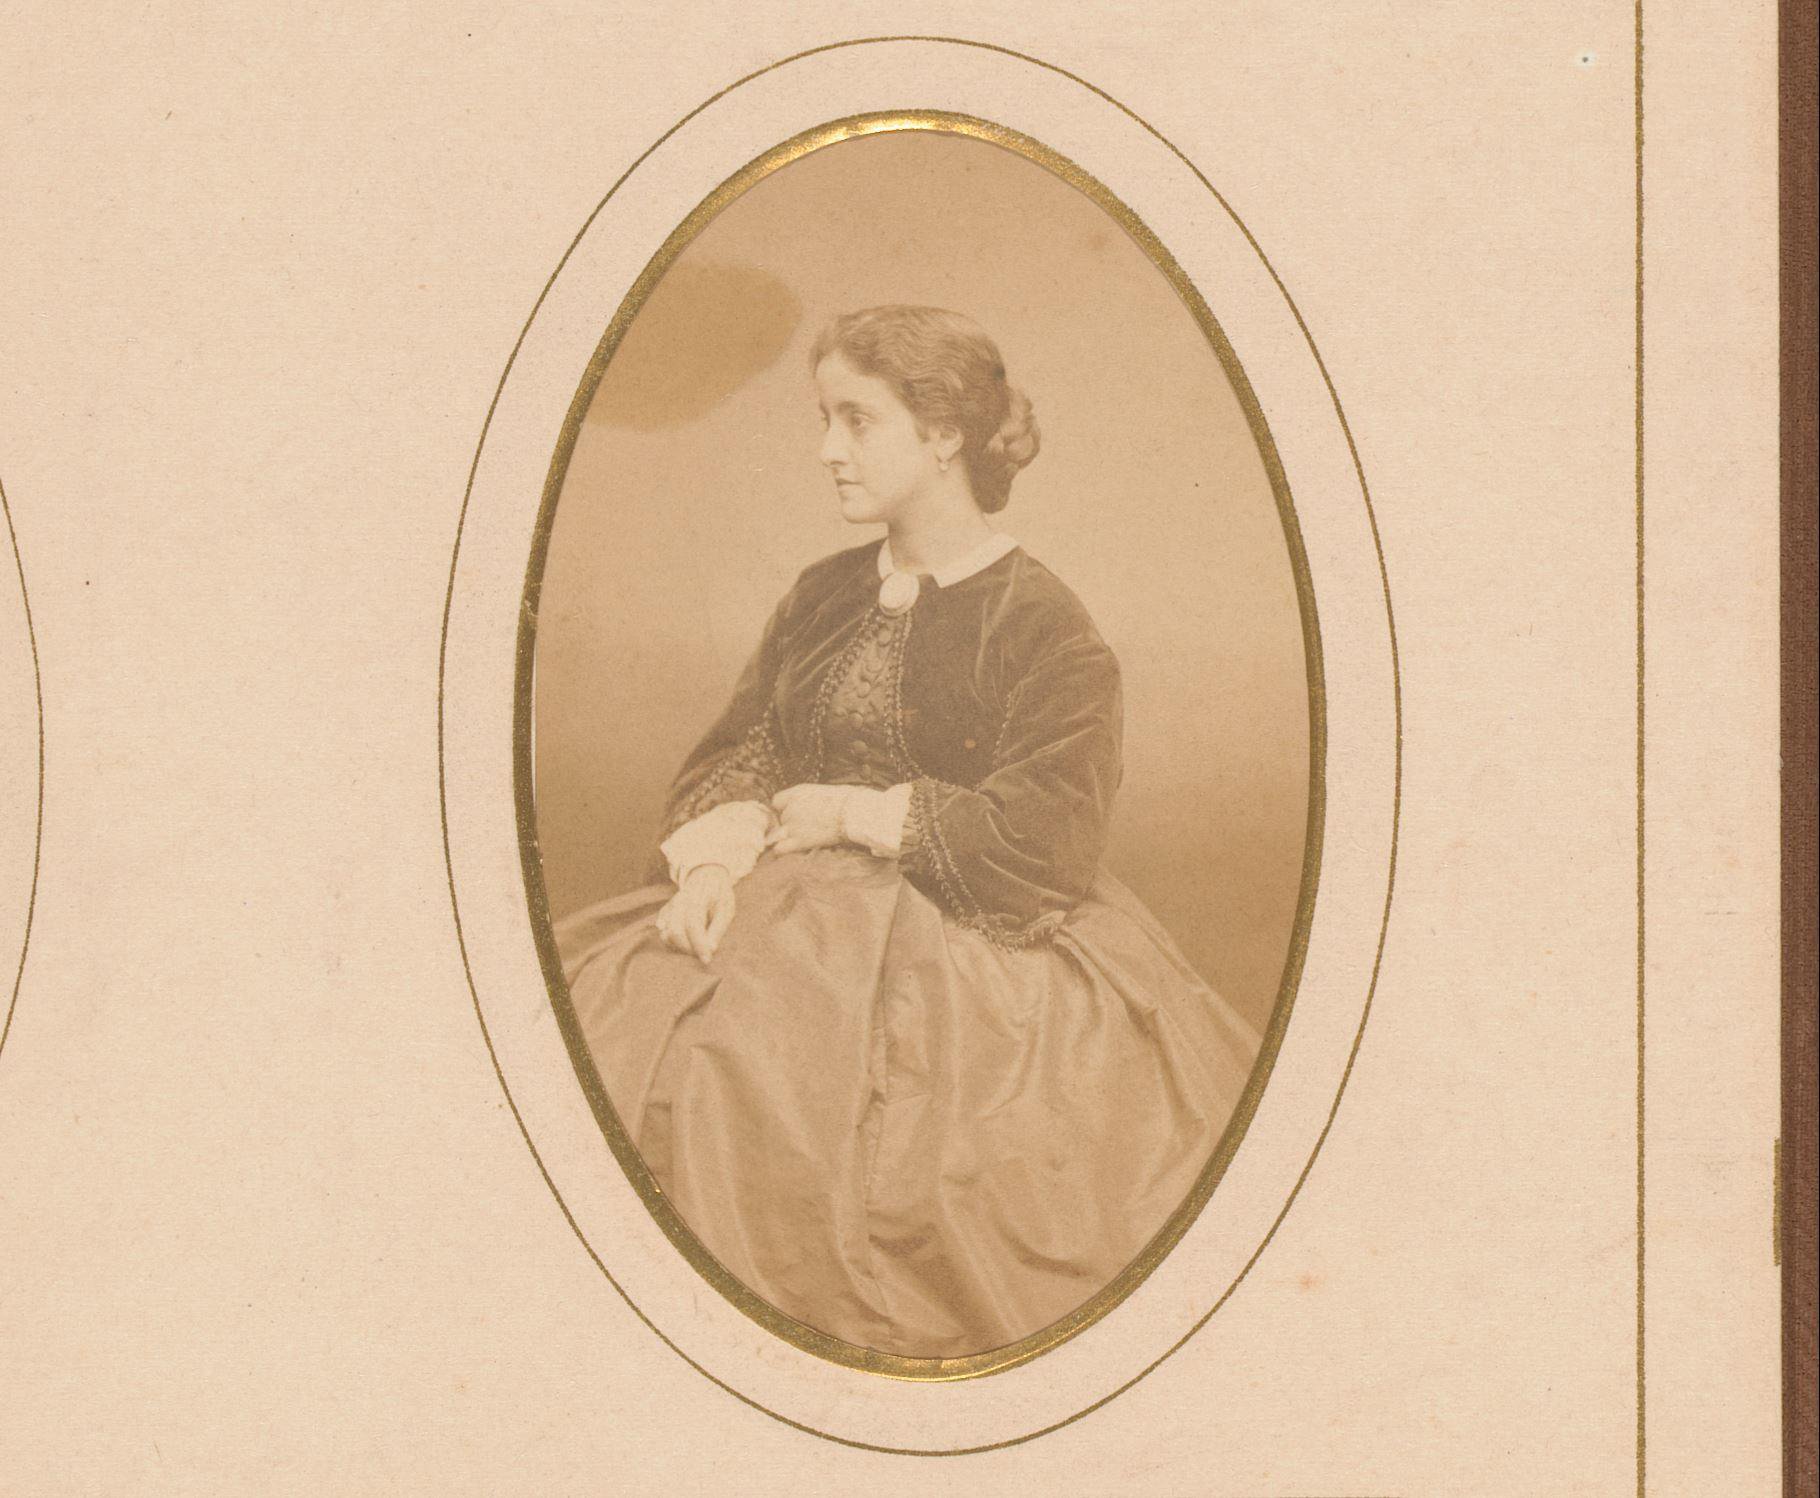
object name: carte de visite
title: Portret van een vrouw met medaillon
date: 1855-1880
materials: cardboard, photographic support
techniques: albumen print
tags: historical persons - bb - woman, ornaments, jewels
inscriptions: inscription: ‘MAYER & PIERSON/ PHOTOGRAPHES DE S.M. L'EMPEREUR/ Boulevart des Capucines 3./ PARIS’